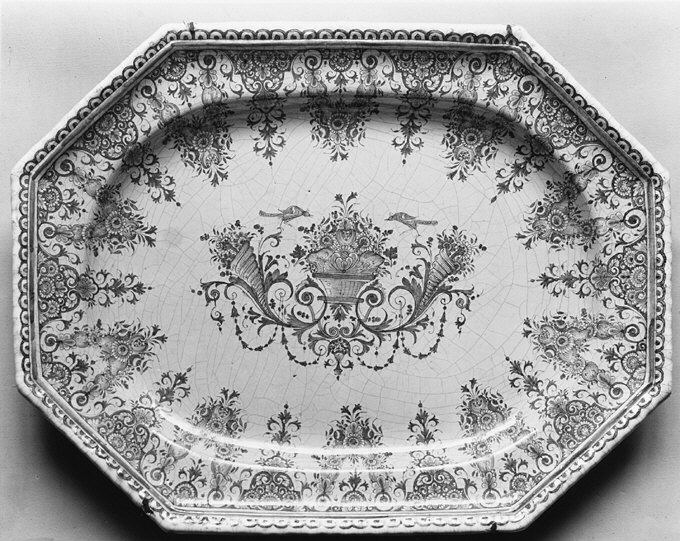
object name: plateau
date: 1705-1720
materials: faience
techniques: glazing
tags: birds,cornucopia